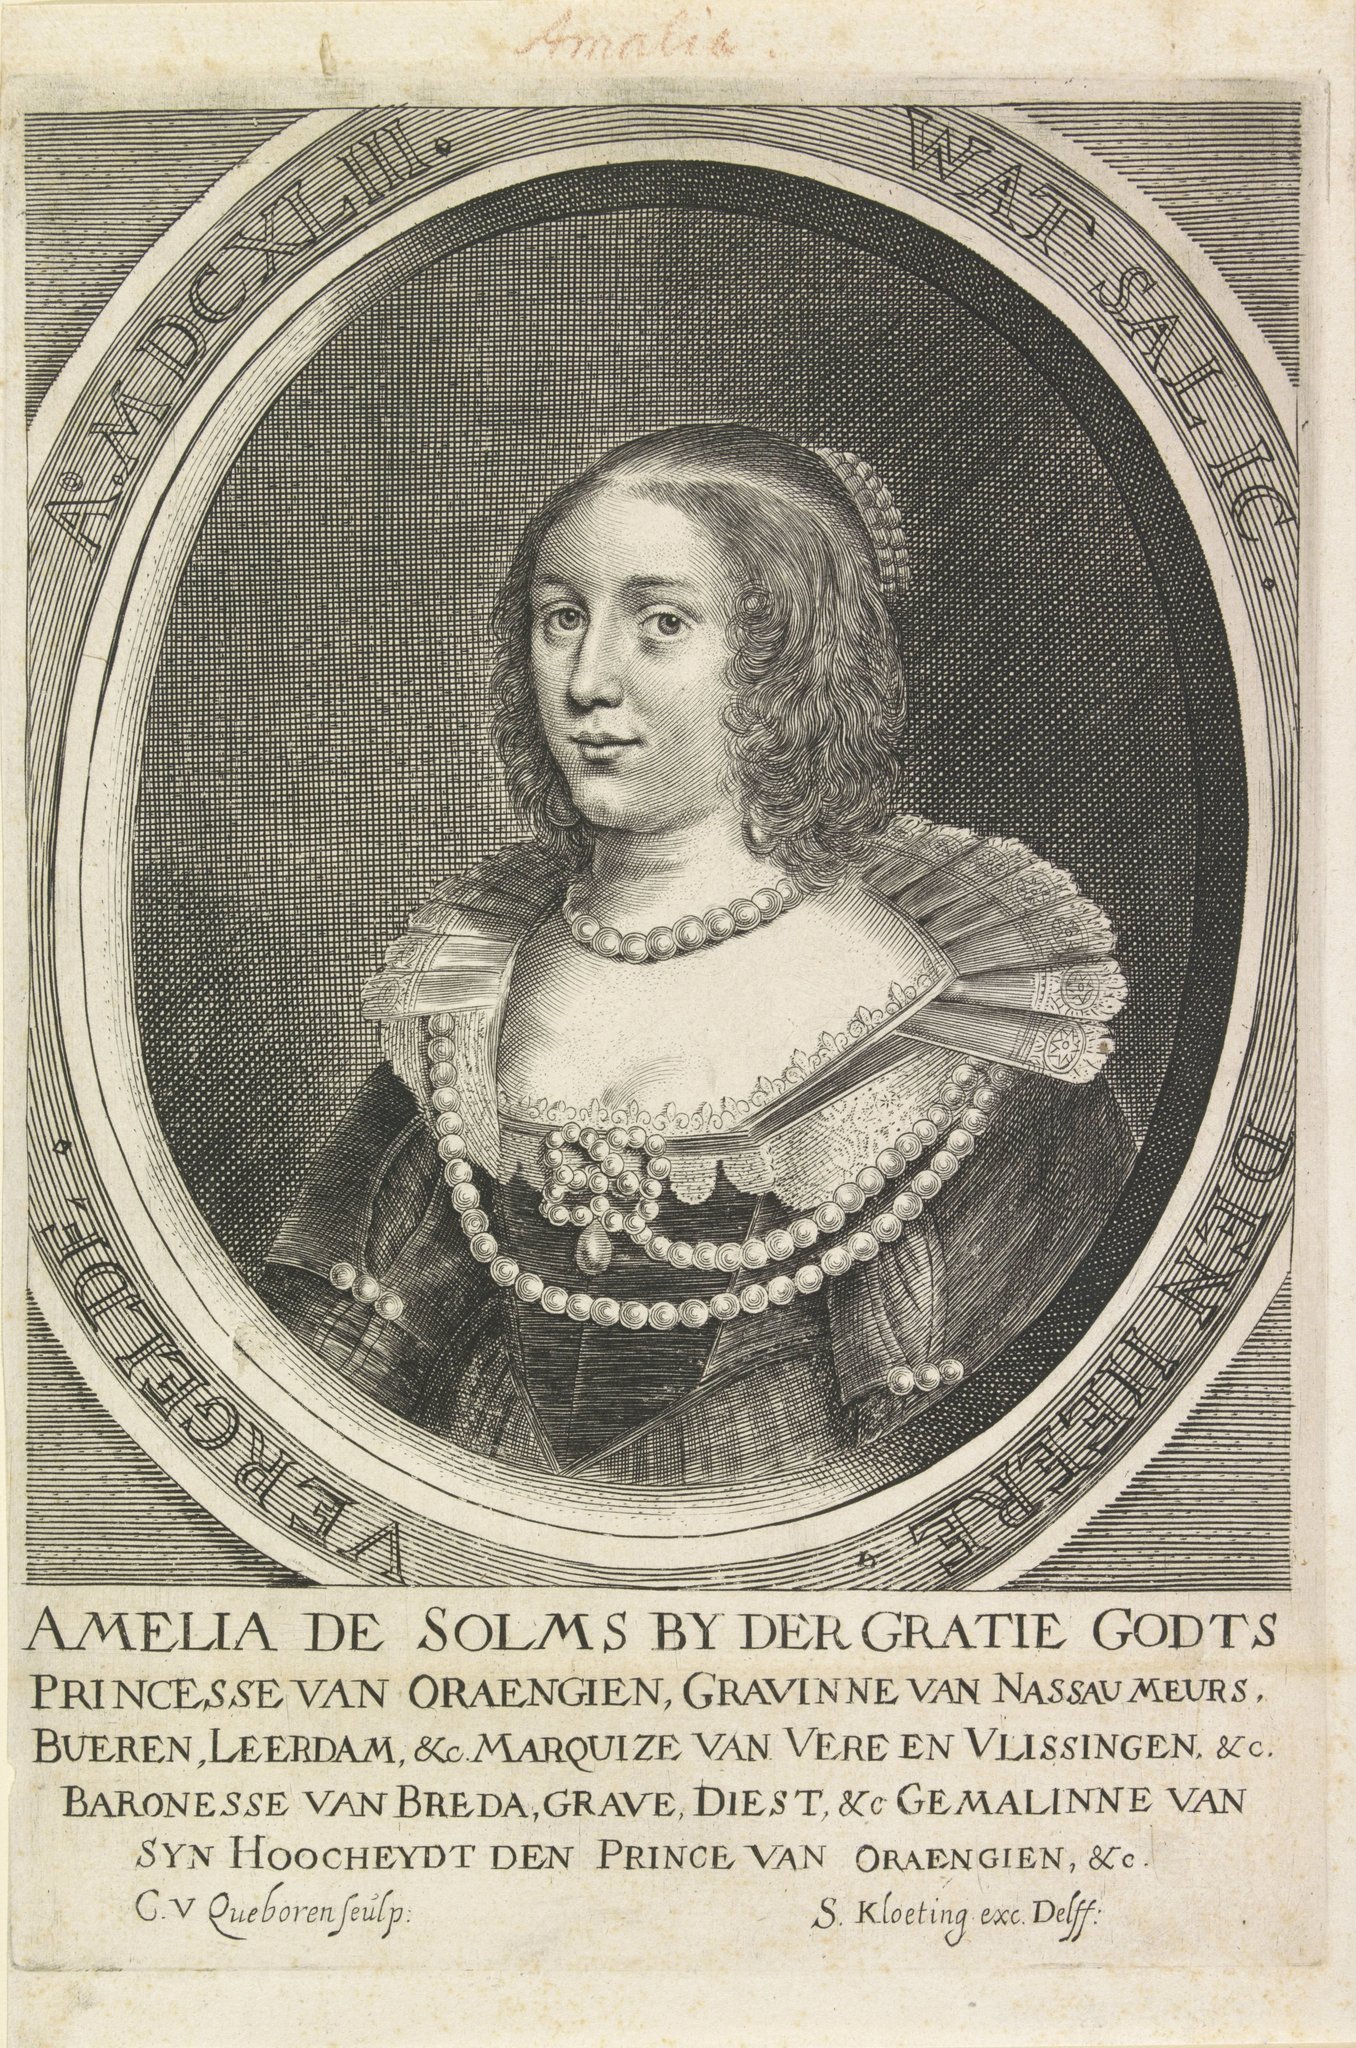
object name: print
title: Portret van Amalia van Solms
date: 1645-1674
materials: paper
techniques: engraving, etching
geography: delft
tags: amalia of solms-braunfels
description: Portret van Amalia in een ovaal met randschrift. In de ondermarge vijf regels Nederlandse tekst.